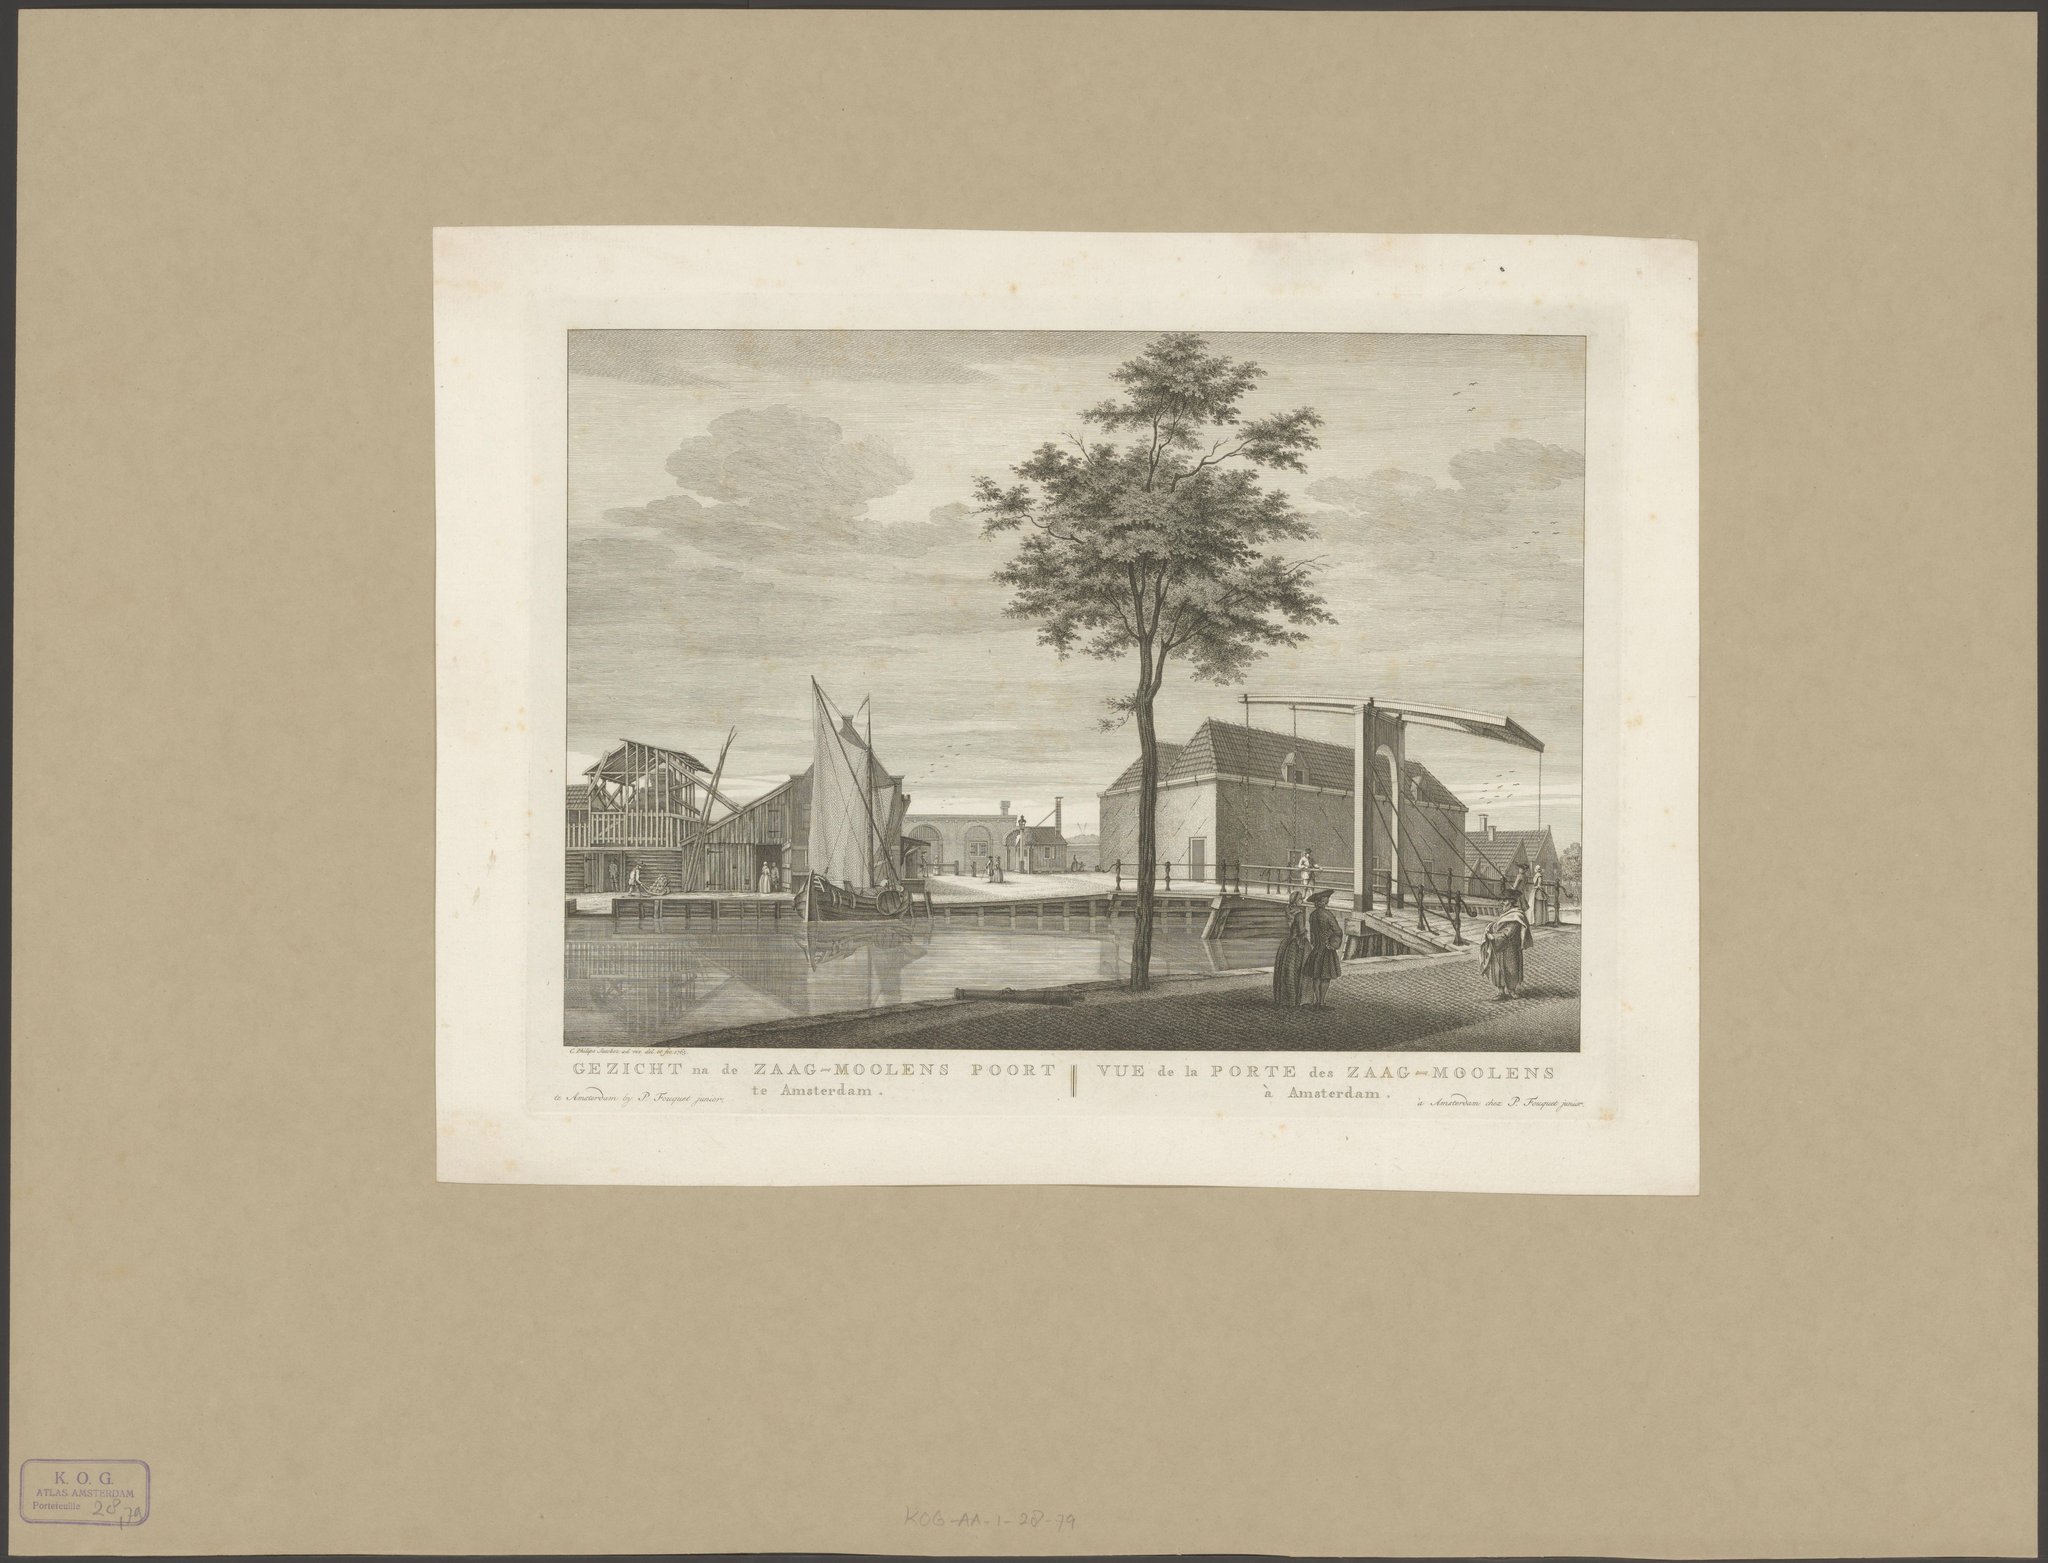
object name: print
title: Atlas van Fouquet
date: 1765-1783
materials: paper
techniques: engraving, etching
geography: amsterdam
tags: bridge in city across river, canal, etc. (+ city(-scape) with figures, staffage), sailing-ship, sailing-boat, city-gate, street (+ city(-scape) with figures, staffage)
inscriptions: collector's mark: Lugt 1641b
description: Vanaf 1760 gaf Pierre Fouquet stadsgezichten van Amsterdam naar tekeningen van verschillende kunstenaars uit. Deze prenten werden aanvankelijk los verkocht. Later werden ze samengebonden verkocht in verschillende volgordes en aantallen in: (1). Afbeeldingen van de wyd-vermaarde koopstad Amsterdam benevens des zelvs voornaamste gebouwen en gezigten alle naar het leeven getekend / Receuil des edifices les plus considerables et des plus belles vues, de la fameuse ville d'Amsterdam, dessinées d'après nature. Amsterdam: Pierre Fouquet, 1778-1783. Deze 'uitgave' bestond waarschijnlijk alleen uit een titelblad en inhoudsopgave van de tot dusver 100 uitgegeven prenten, die de koper zelf aan zijn of haar reeds verzamelde prenten kon toevoegen. De hoeveelheid en volgorde van prenten verzameld onder deze titel verschilt dus sterk. (2). Nieuwe atlas, van de voornaamste gebouwen en gezigten der stad Amsterdam, met derzelver beknopte beschryvingen. 2 dln. Amsterdam: Daniël Jean Changuion en Petrus den Hengst [in opdracht van Pierre Fouquet], 1783. Ook werden er door verschillende uitgevers tussen 1788 (Amsterdam: Petrus Conradi) en 1805 (Amsterdam: Evert Maaskamp) heruitgaven gepubliceerd.